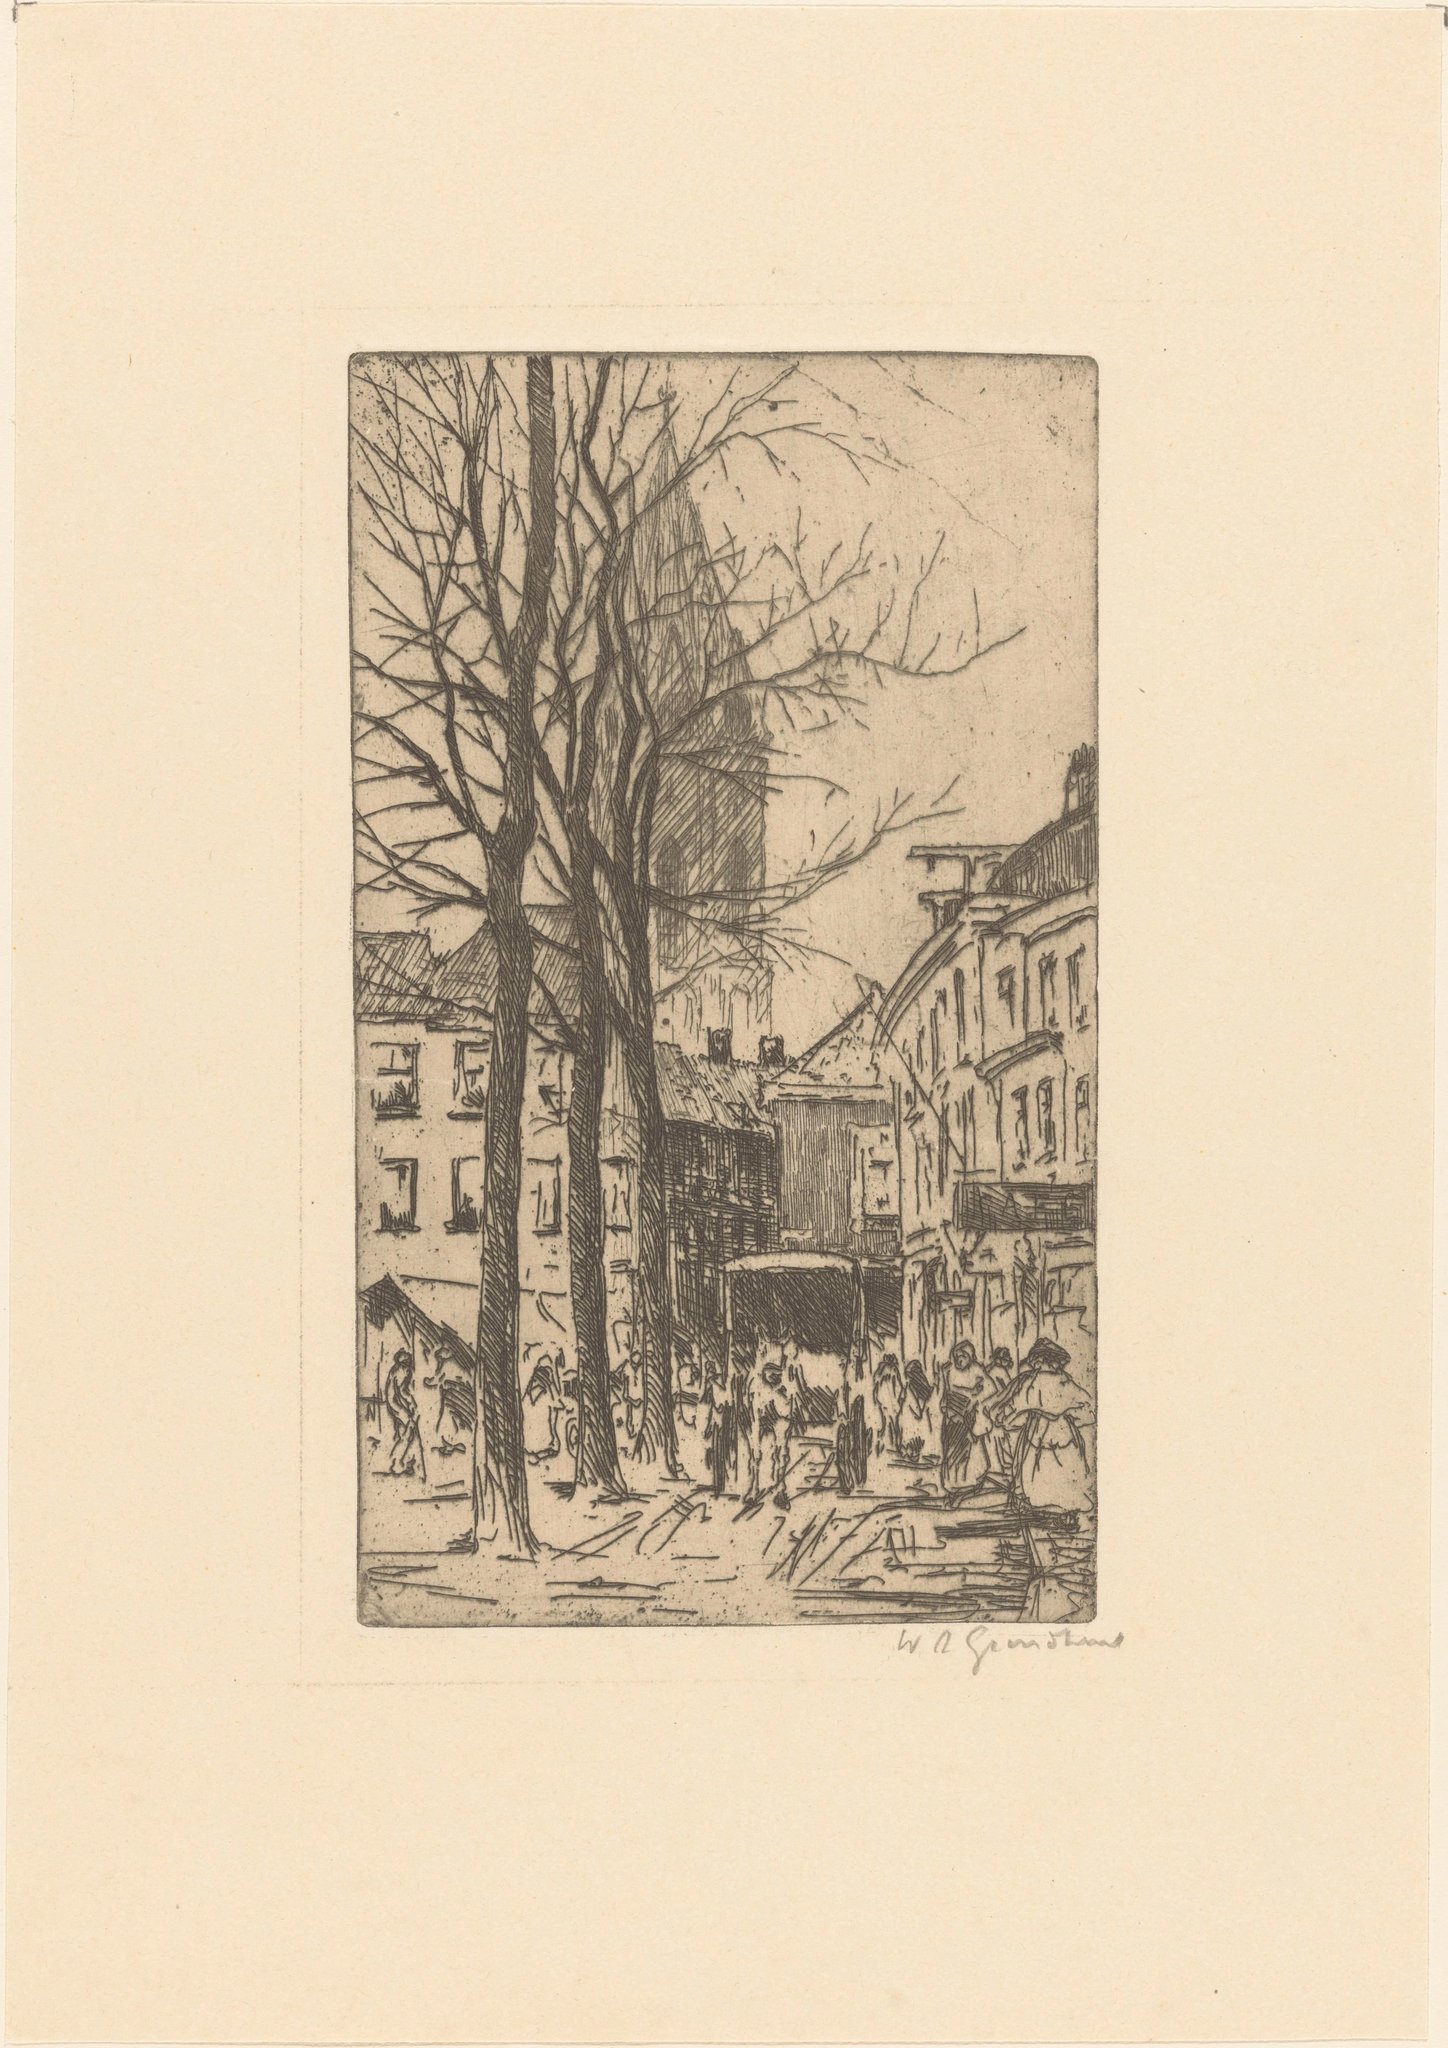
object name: print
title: Figuren op straat in Den Haag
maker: willem adrianus grondhout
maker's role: draughtsman, painter, print maker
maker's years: 1878-1934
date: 1888-1934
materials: paper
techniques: etching, intaglio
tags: street, parts of church exterior and annexes: tower, the hague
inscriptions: collector's mark: Lugt 2228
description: Op de achtergrond de toren van een kerk.